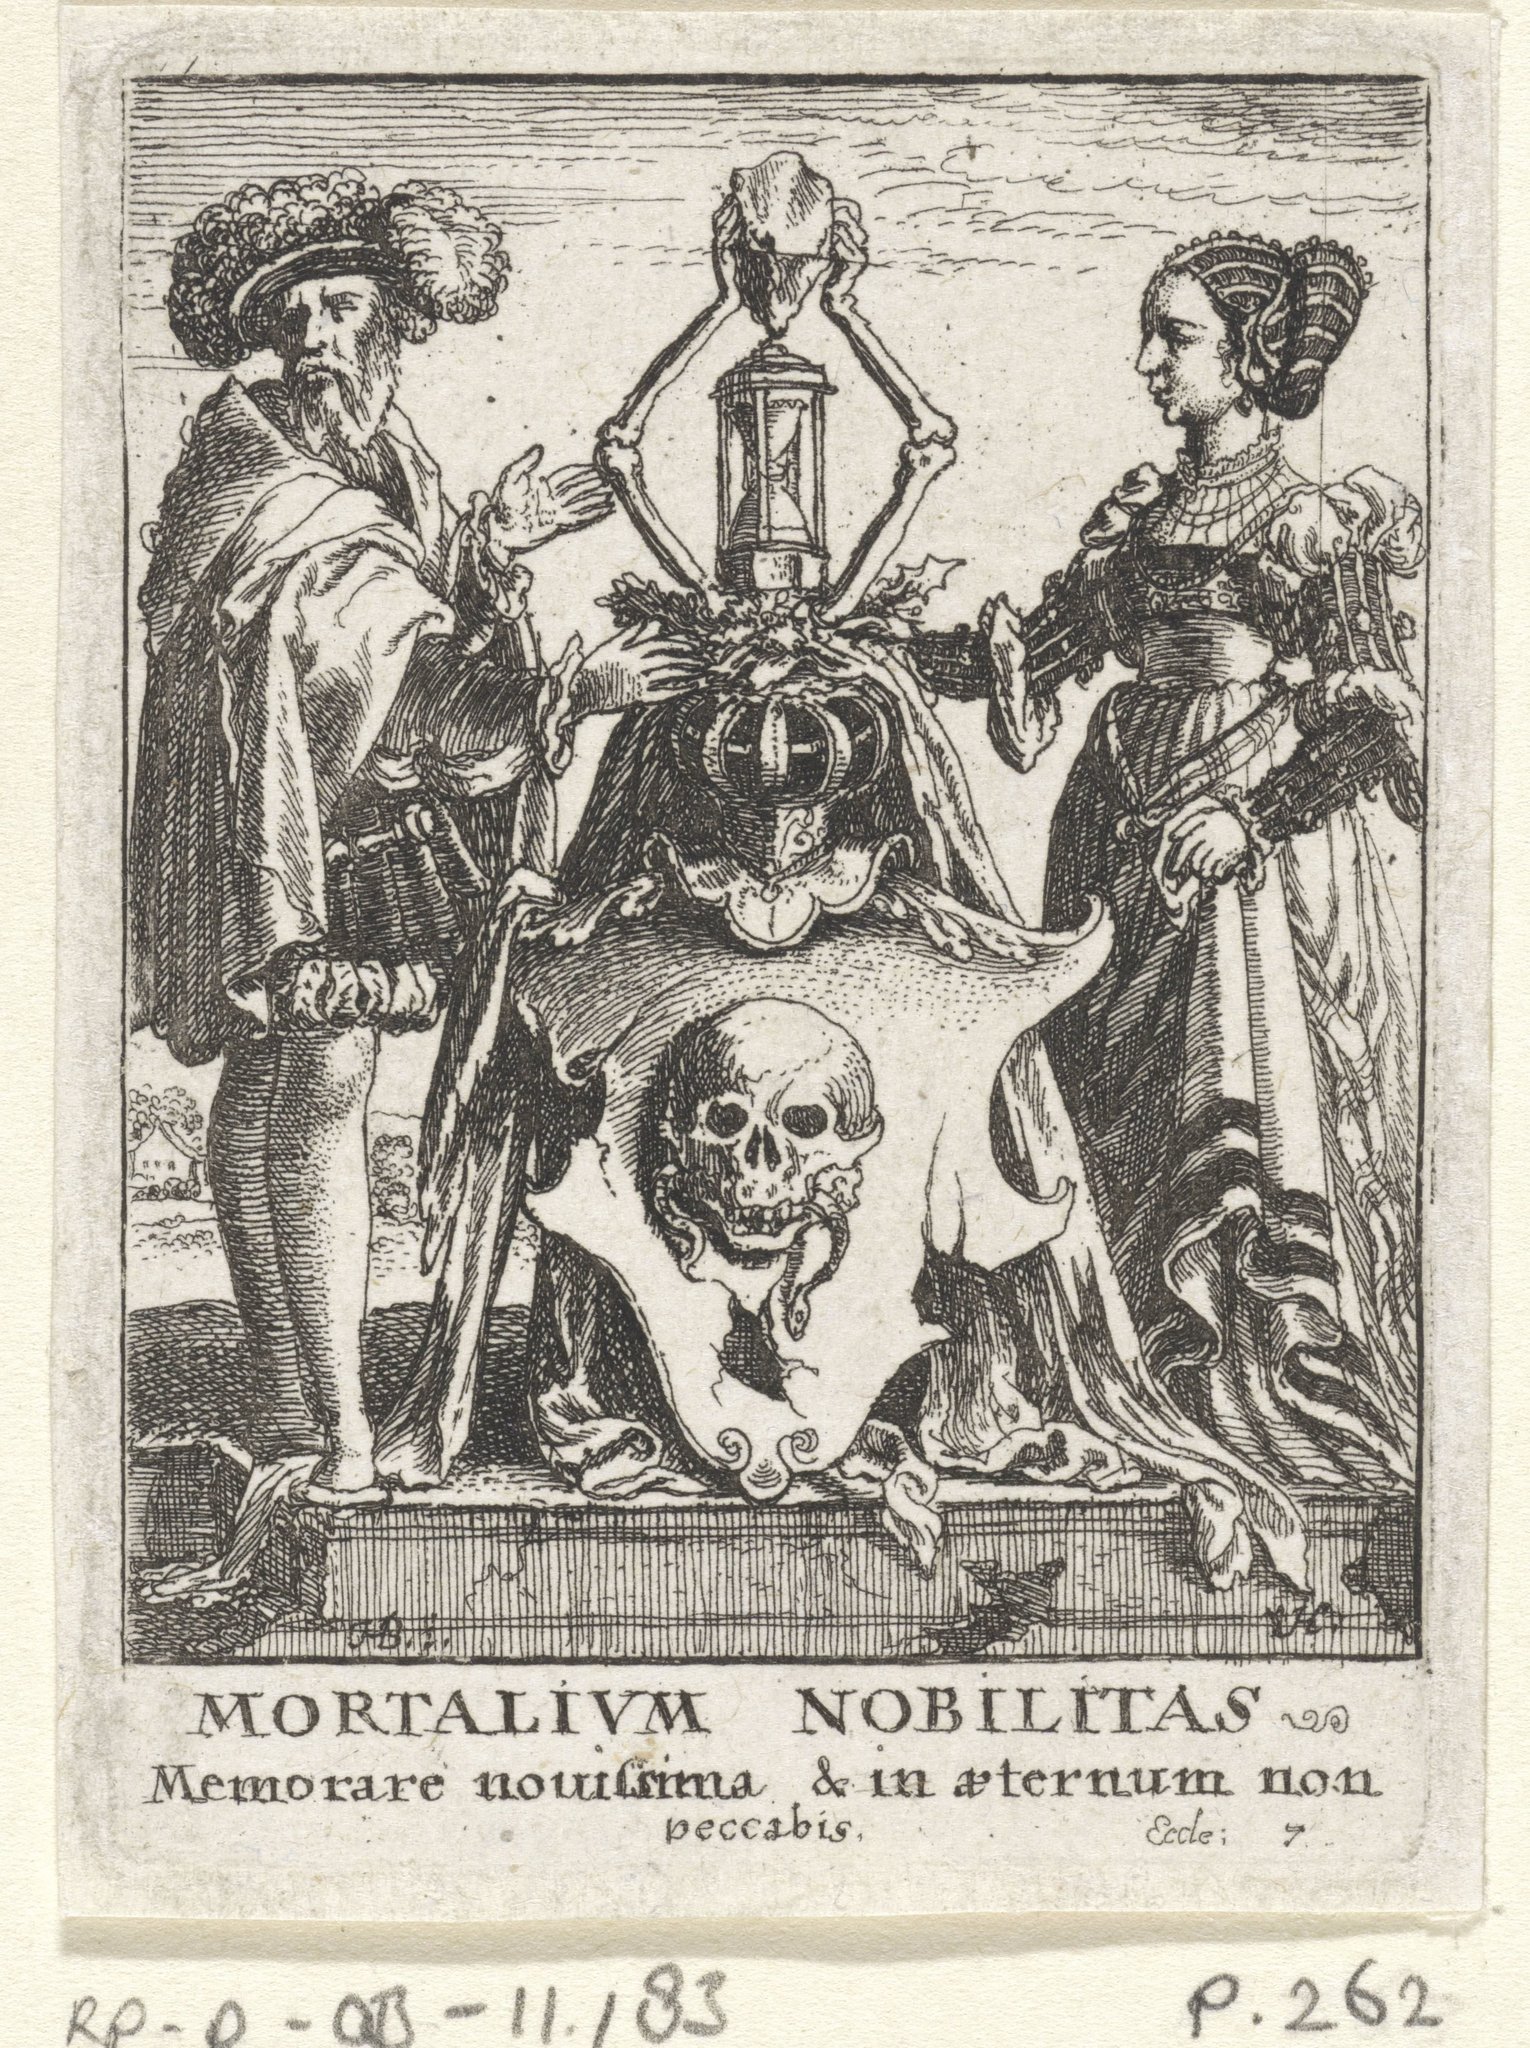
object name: print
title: Dodendans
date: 1680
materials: paper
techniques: etching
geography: antwerp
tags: coat of arms (symbol of sovereignty), dance of death; death together with one or more human beings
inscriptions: collector's mark: Lugt 240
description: Een man en een vrouw staan op een sokkel aan weerszijden van het wapen van de Dood.